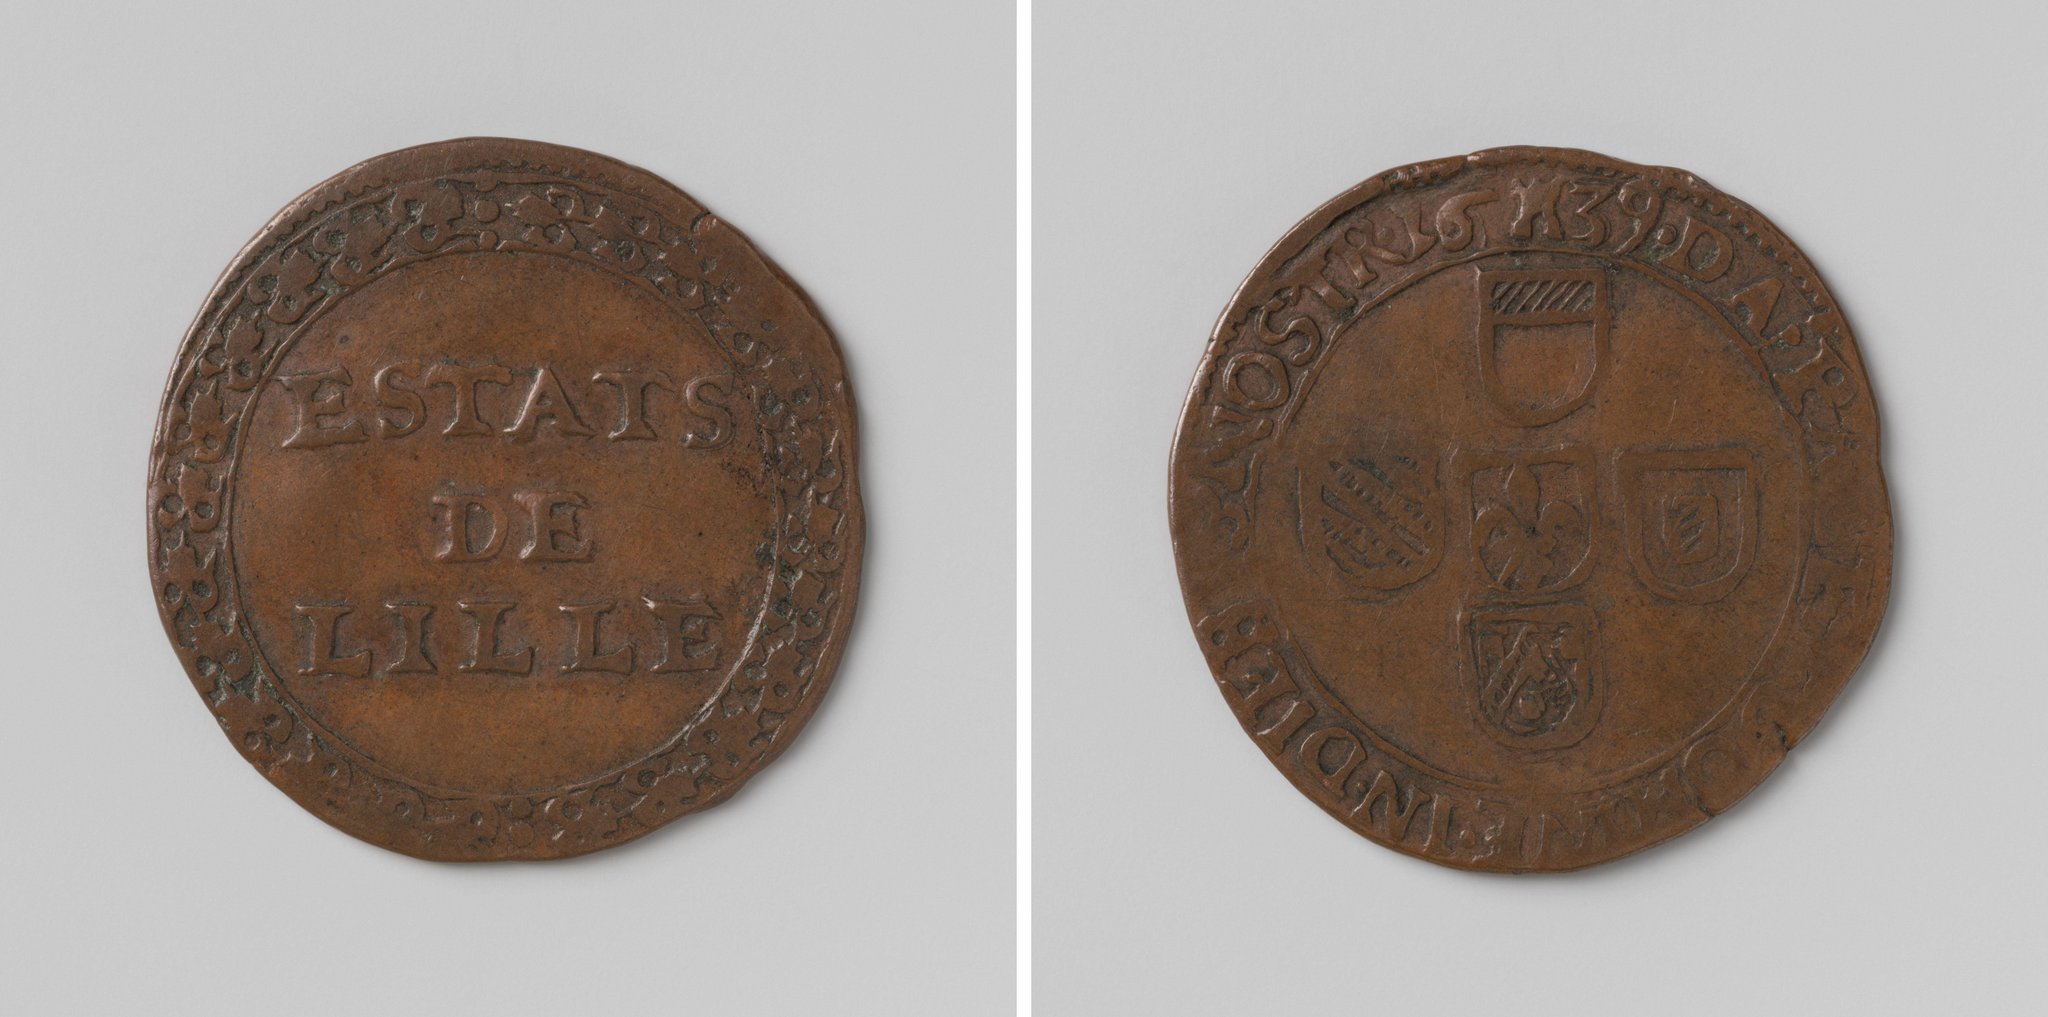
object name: jeton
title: Hoop op vrede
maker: Anonymous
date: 1639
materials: copper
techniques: striking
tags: lille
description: Koperen penning. Voorzijde: opschrift binnen lauwerkrans. Keerzijde: wapenschild, omgeven door vier wapenschilden binnen omschrift.